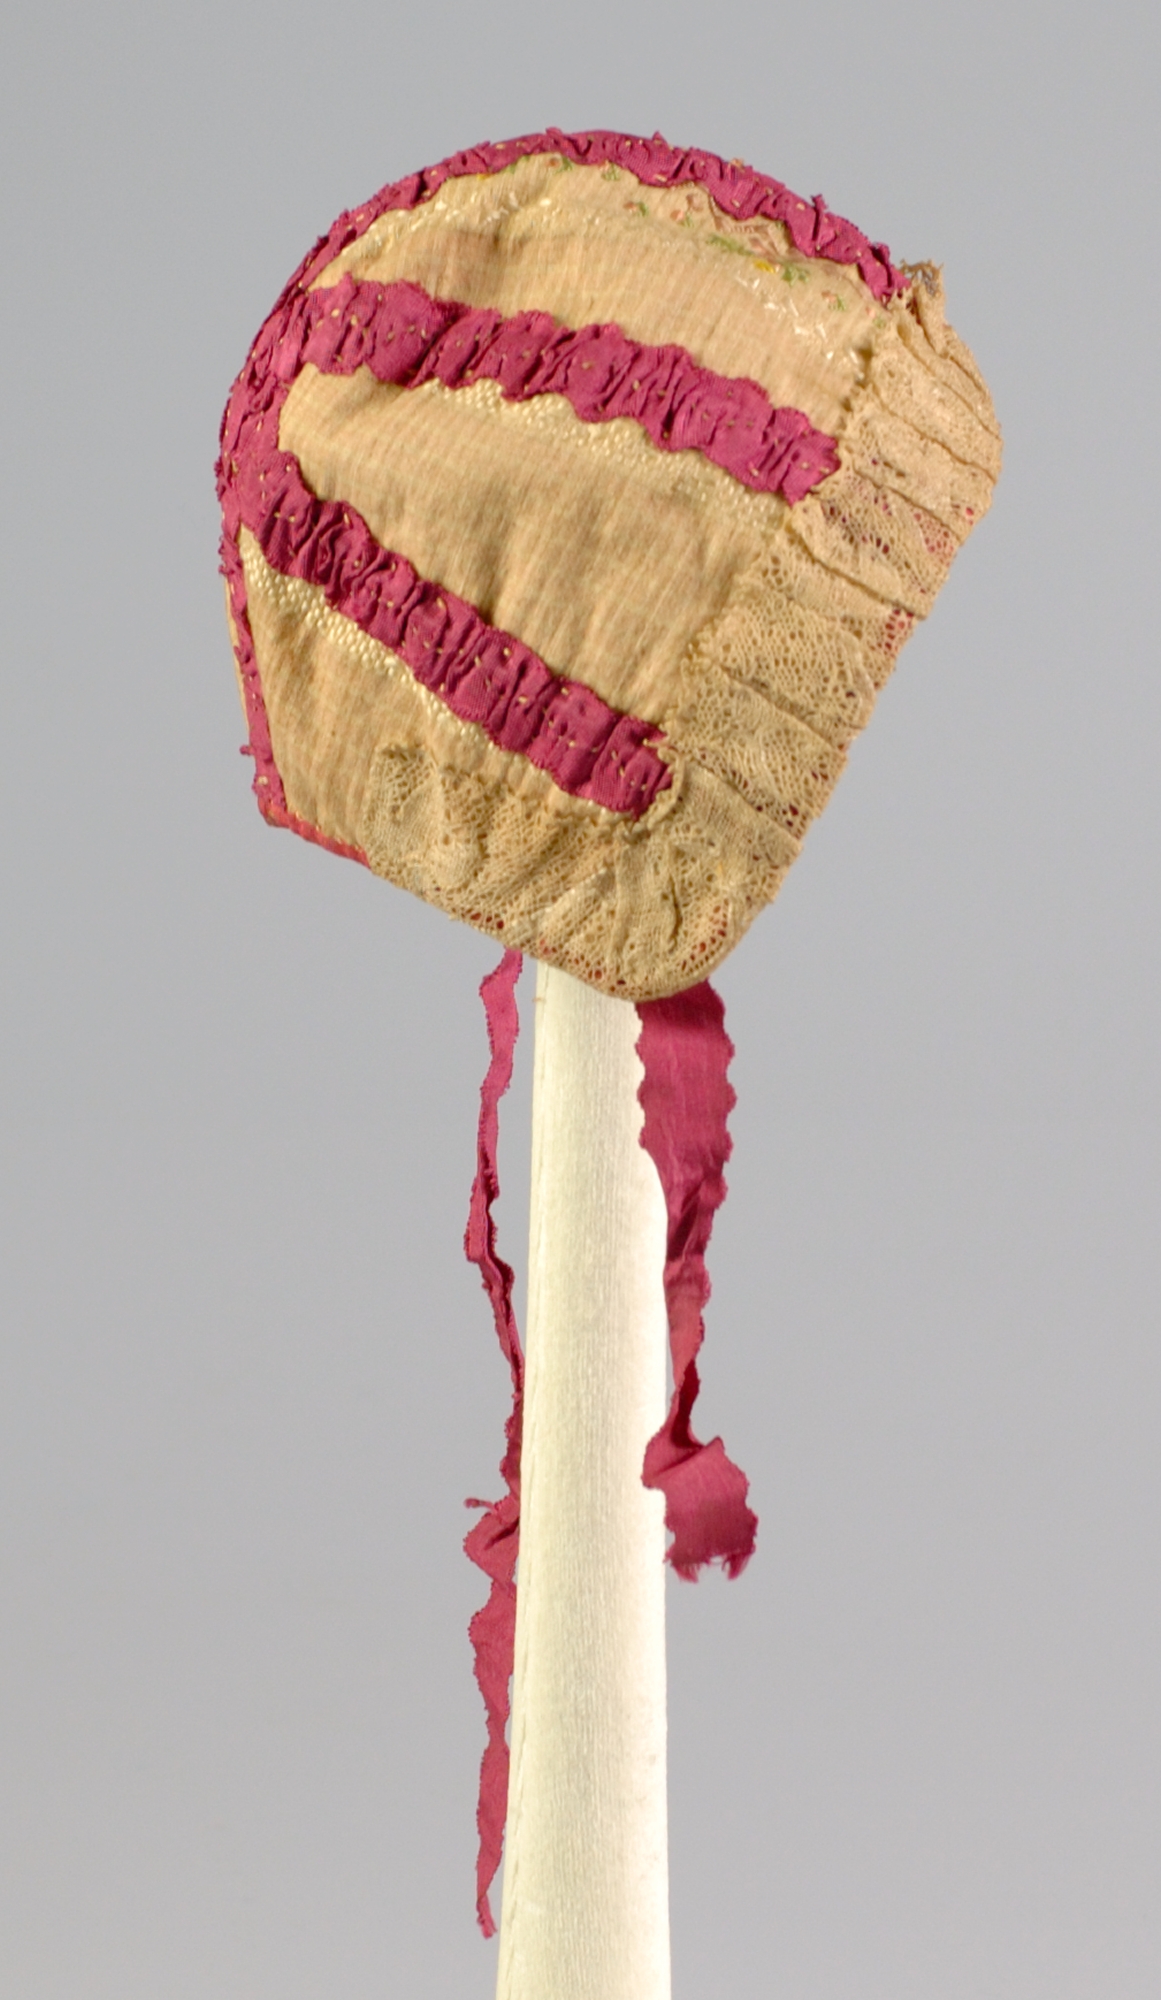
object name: cap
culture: european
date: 1780-1800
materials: cotton, silk